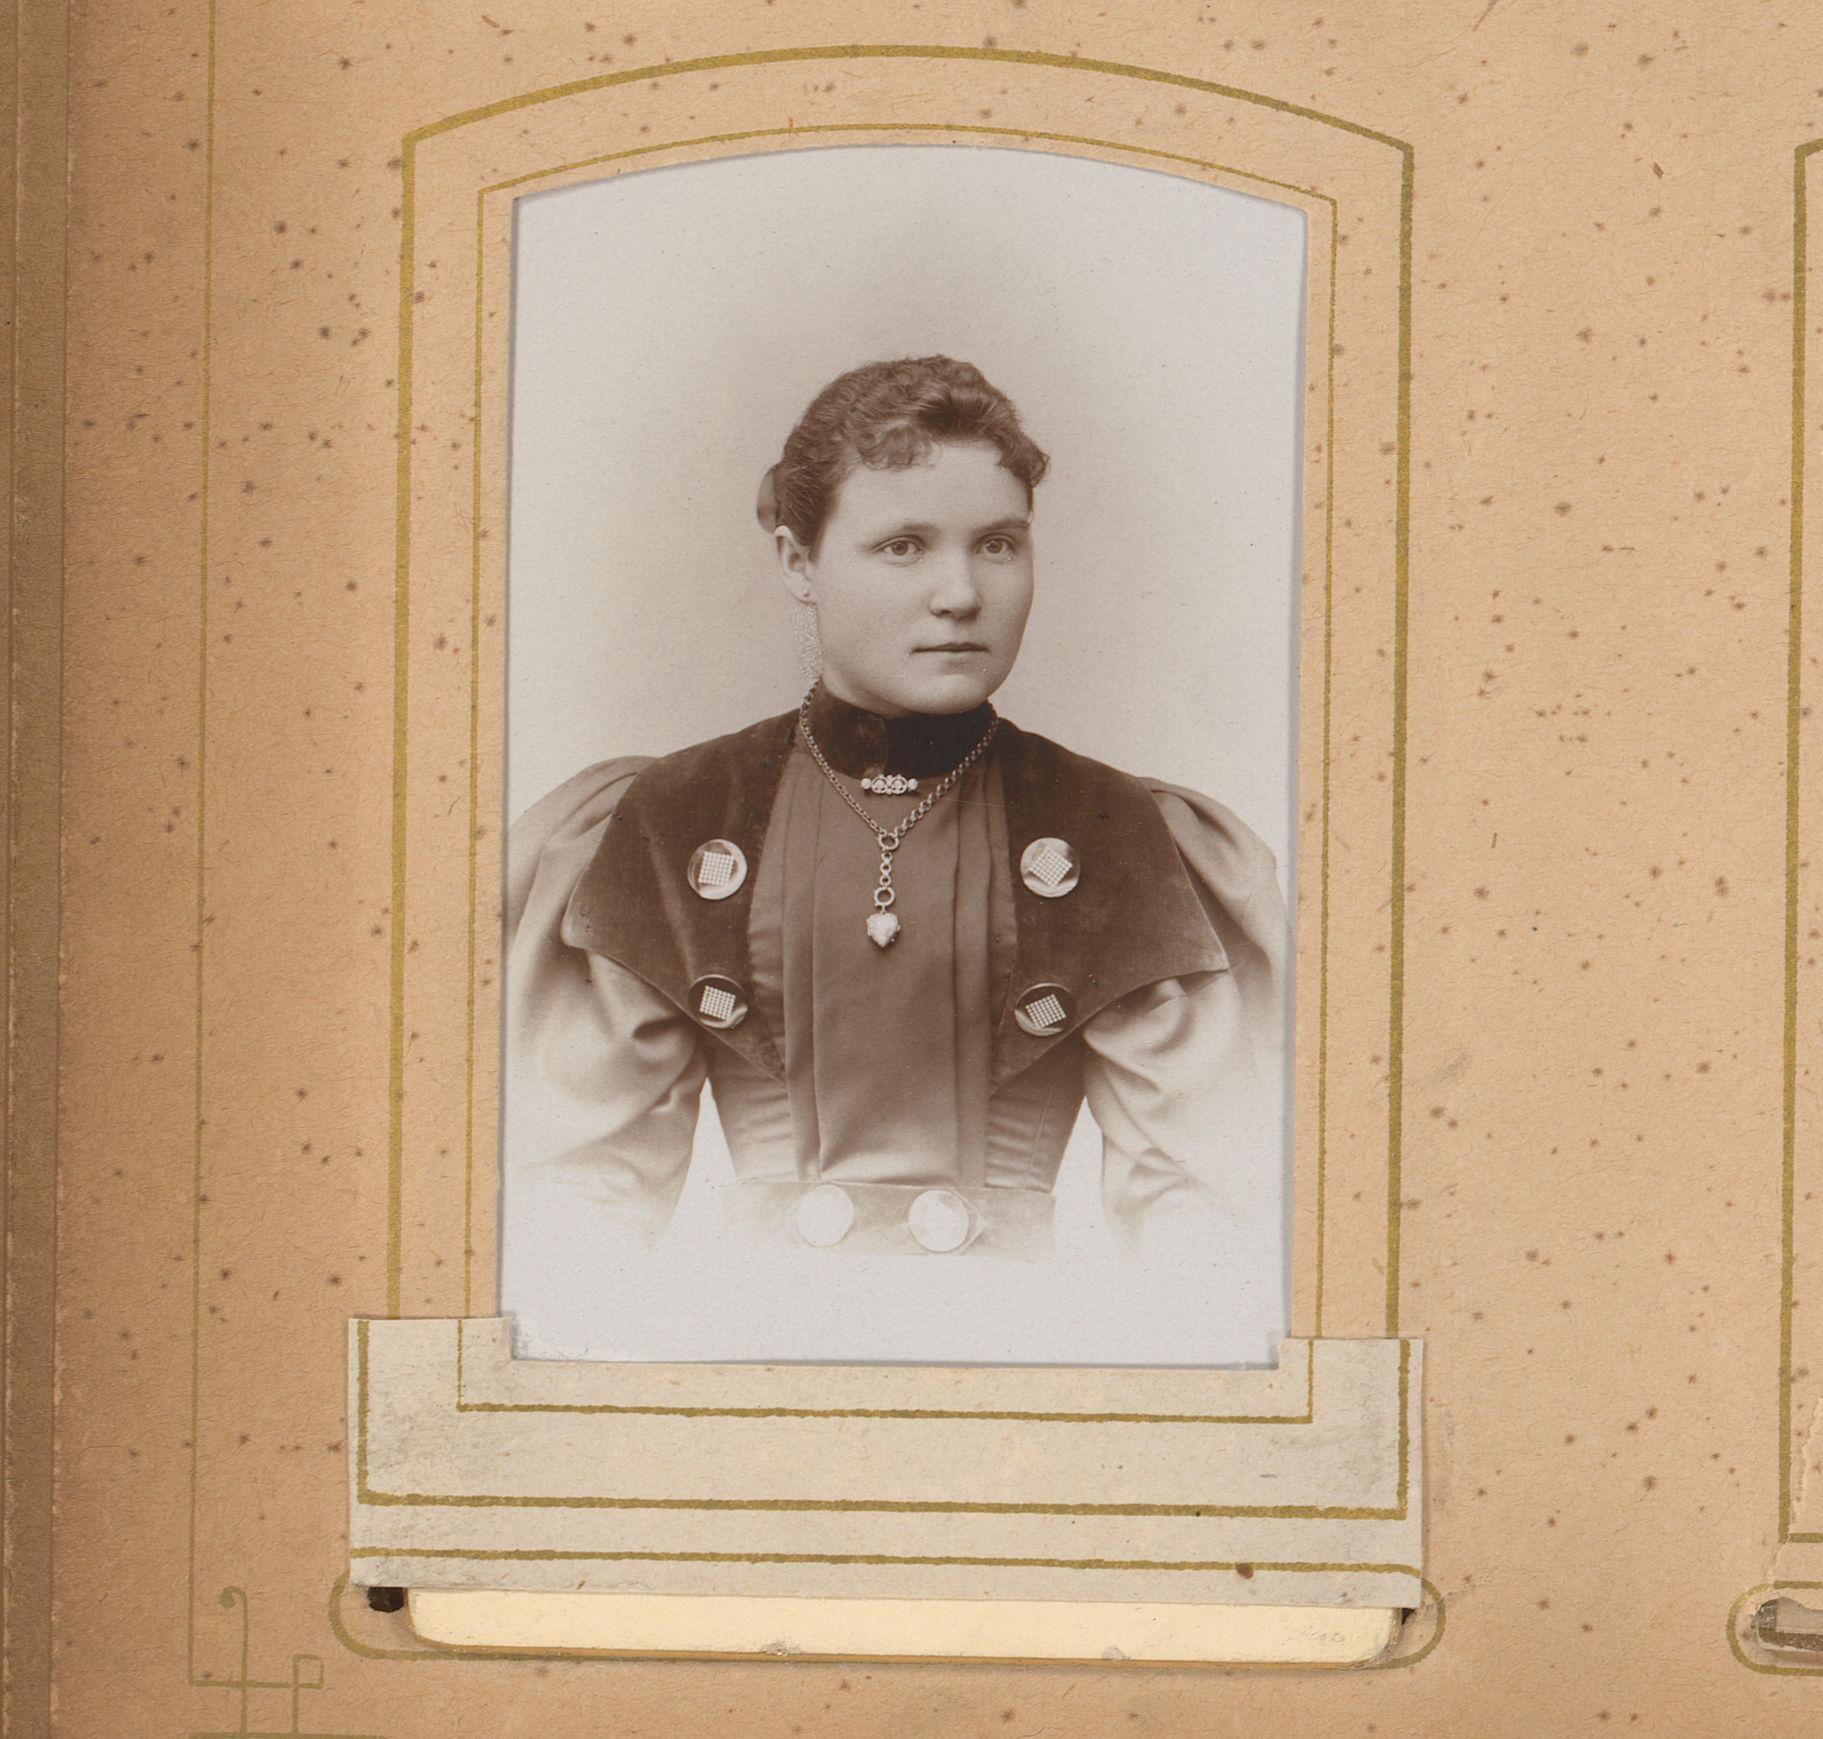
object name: carte de visite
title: Portret van een vrouw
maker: max blum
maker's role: fotograaf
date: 1860-1900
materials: cardboard, photographic support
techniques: albumen print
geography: meerane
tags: historical persons - bb - woman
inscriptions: inscription: ‘Atelier/ Max Blum/ Meerane/ innere Crimmitschauerstr. 9./ Mülsen St. Jacob./ [...]hmen täglich und bei jeder Witte[...]/ [...]’